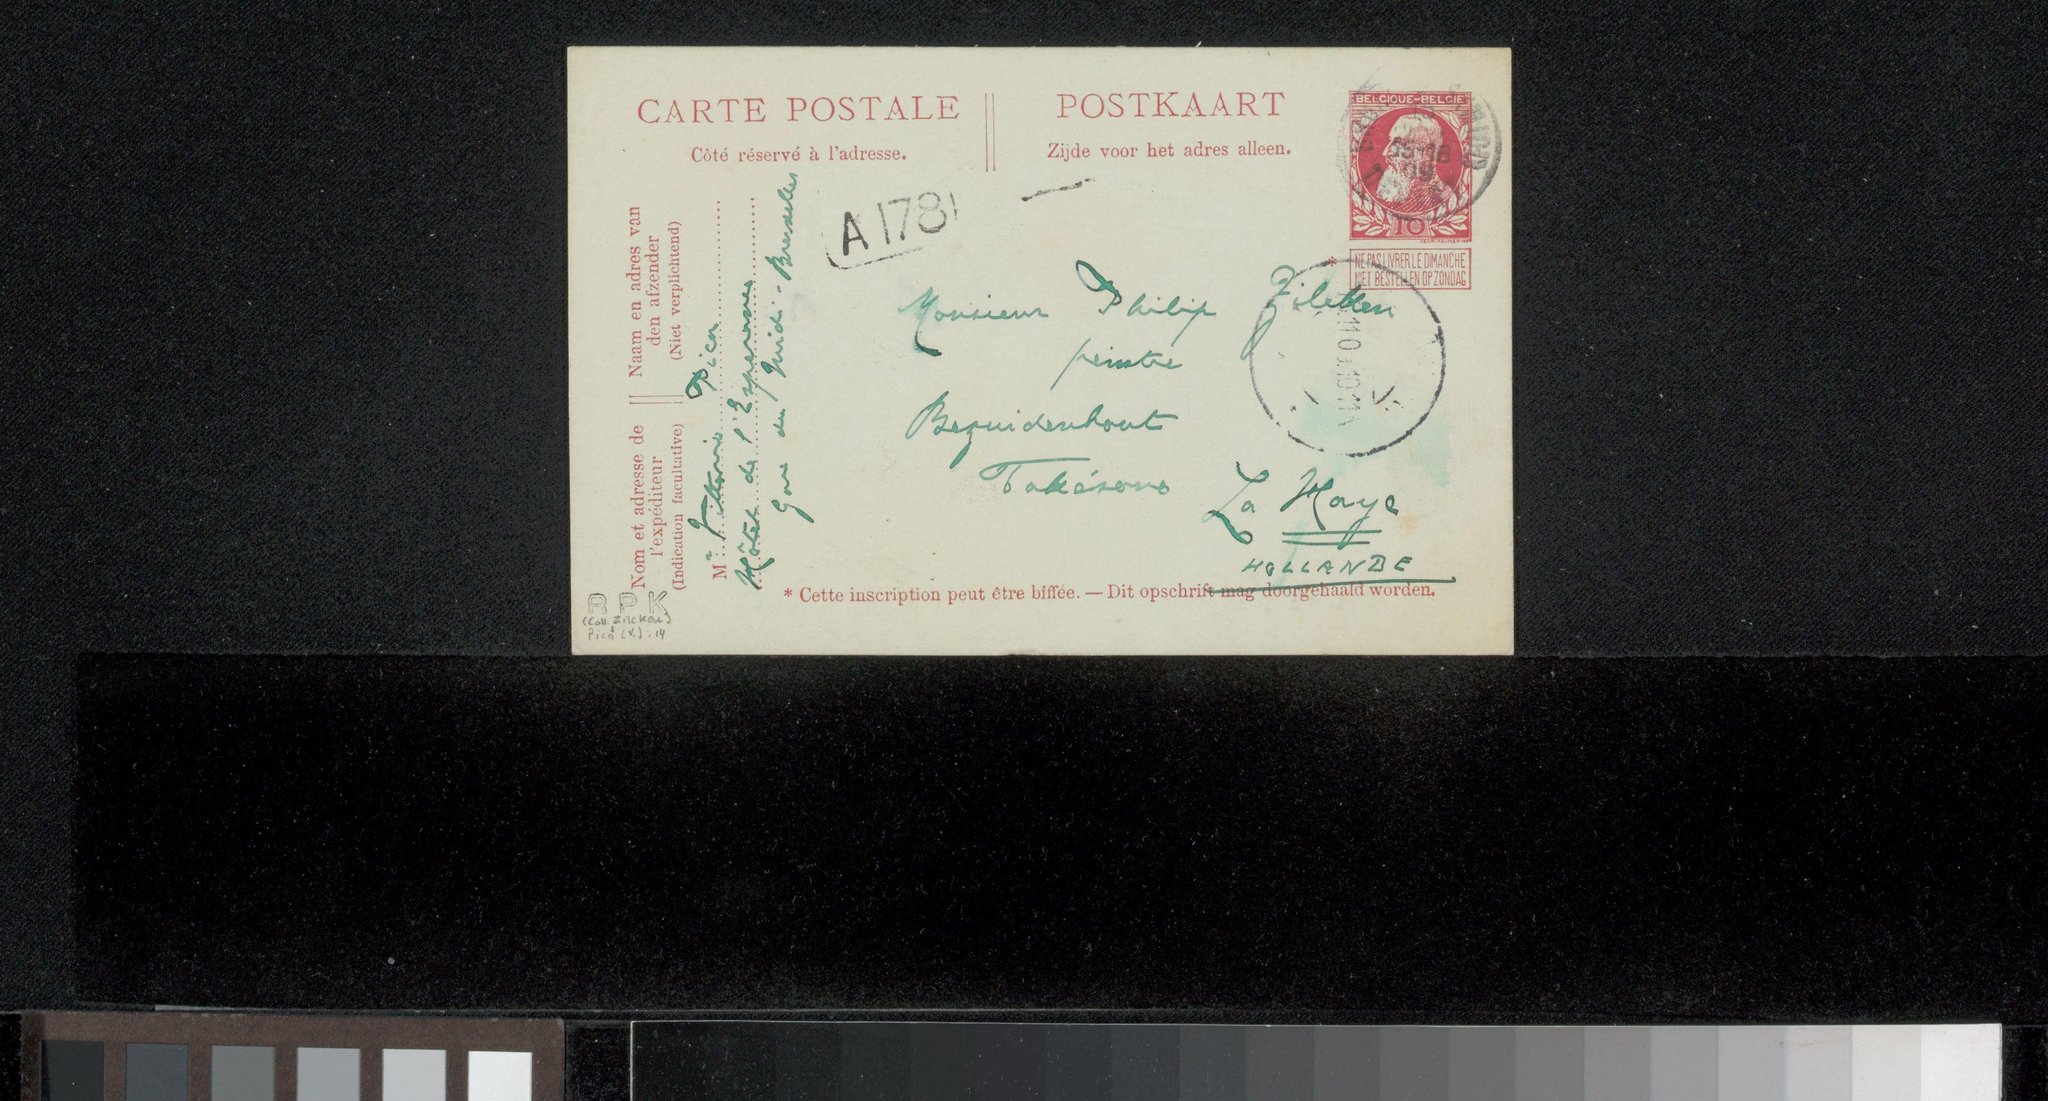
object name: postcard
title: Briefkaart aan Philip Zilcken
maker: vittorio pica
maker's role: criticus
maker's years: 1864-1930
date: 1909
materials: cardboard, ink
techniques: pen, writing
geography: brussels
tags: print maker, jozef israëls, the hague, painter, draughtsman, philip zilcken, photography, cinematography, brussels, paris, rome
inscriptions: collector's mark: ‘RPK’